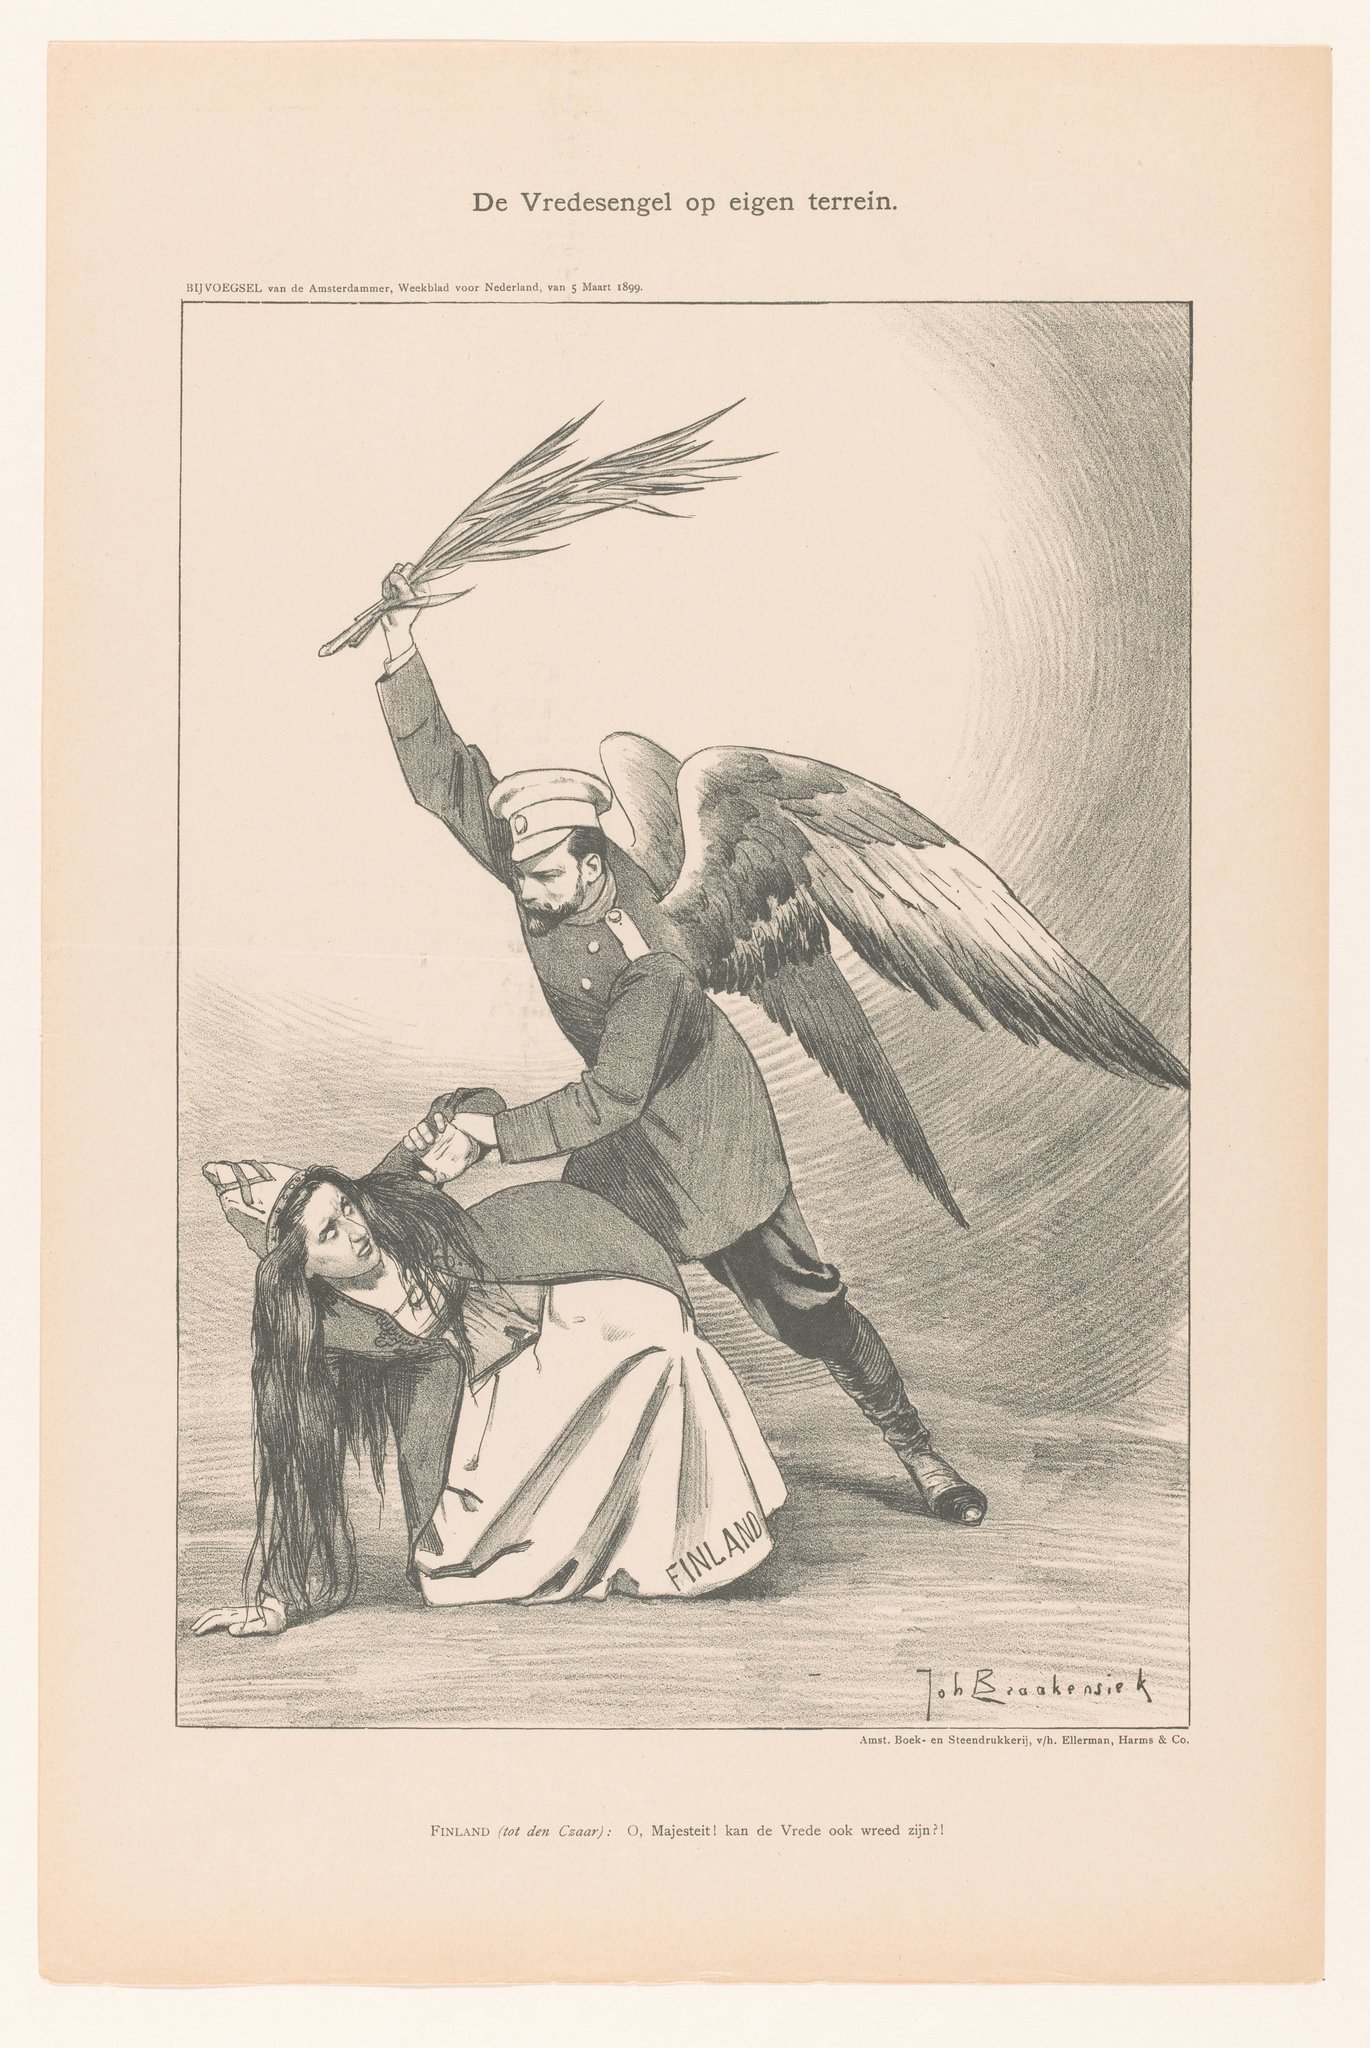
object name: cartoon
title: De Vredesengel op eigen terrein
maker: johan braakensiek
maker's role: draughtsman, print maker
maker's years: 1858-1940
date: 1899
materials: paper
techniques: lithograph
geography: amsterdam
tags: personifications of countries, nations, states, districts, etc., historical persons, emperor, peace, political caricatures and satires, russia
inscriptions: date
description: Prent uit het bijvoegsel van: De Amsterdammer. Weekblad voor Nederland, 5 maart 1899.